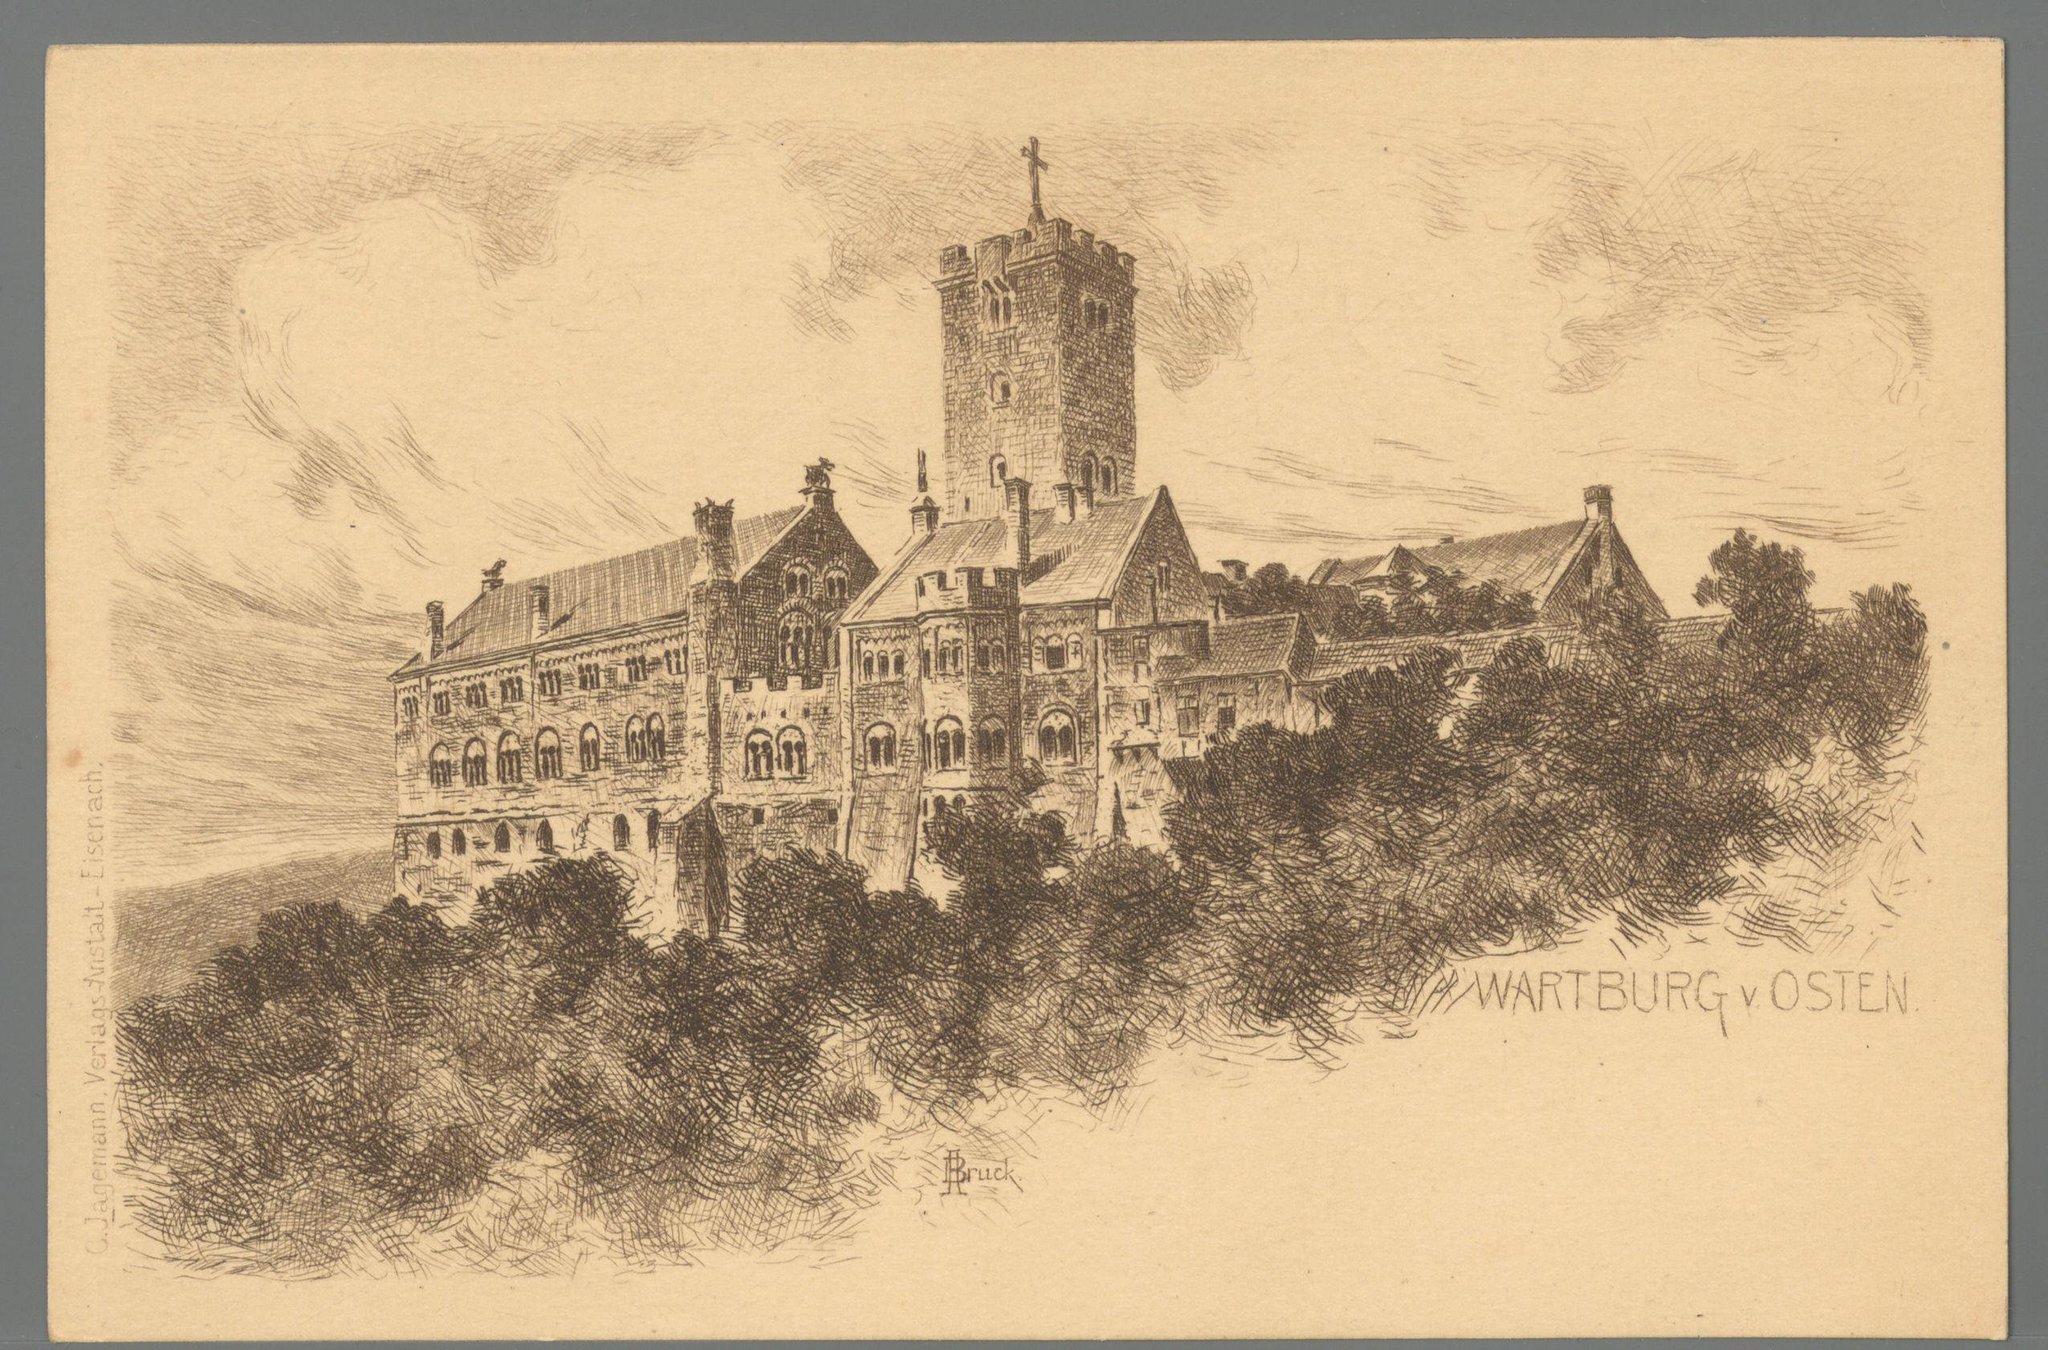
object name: print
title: Wartburg v. Osten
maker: albrecht bruck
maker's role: painter, print maker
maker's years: 1874-1964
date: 1884-1905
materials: cardboard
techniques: etching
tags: landscape with tower or castle